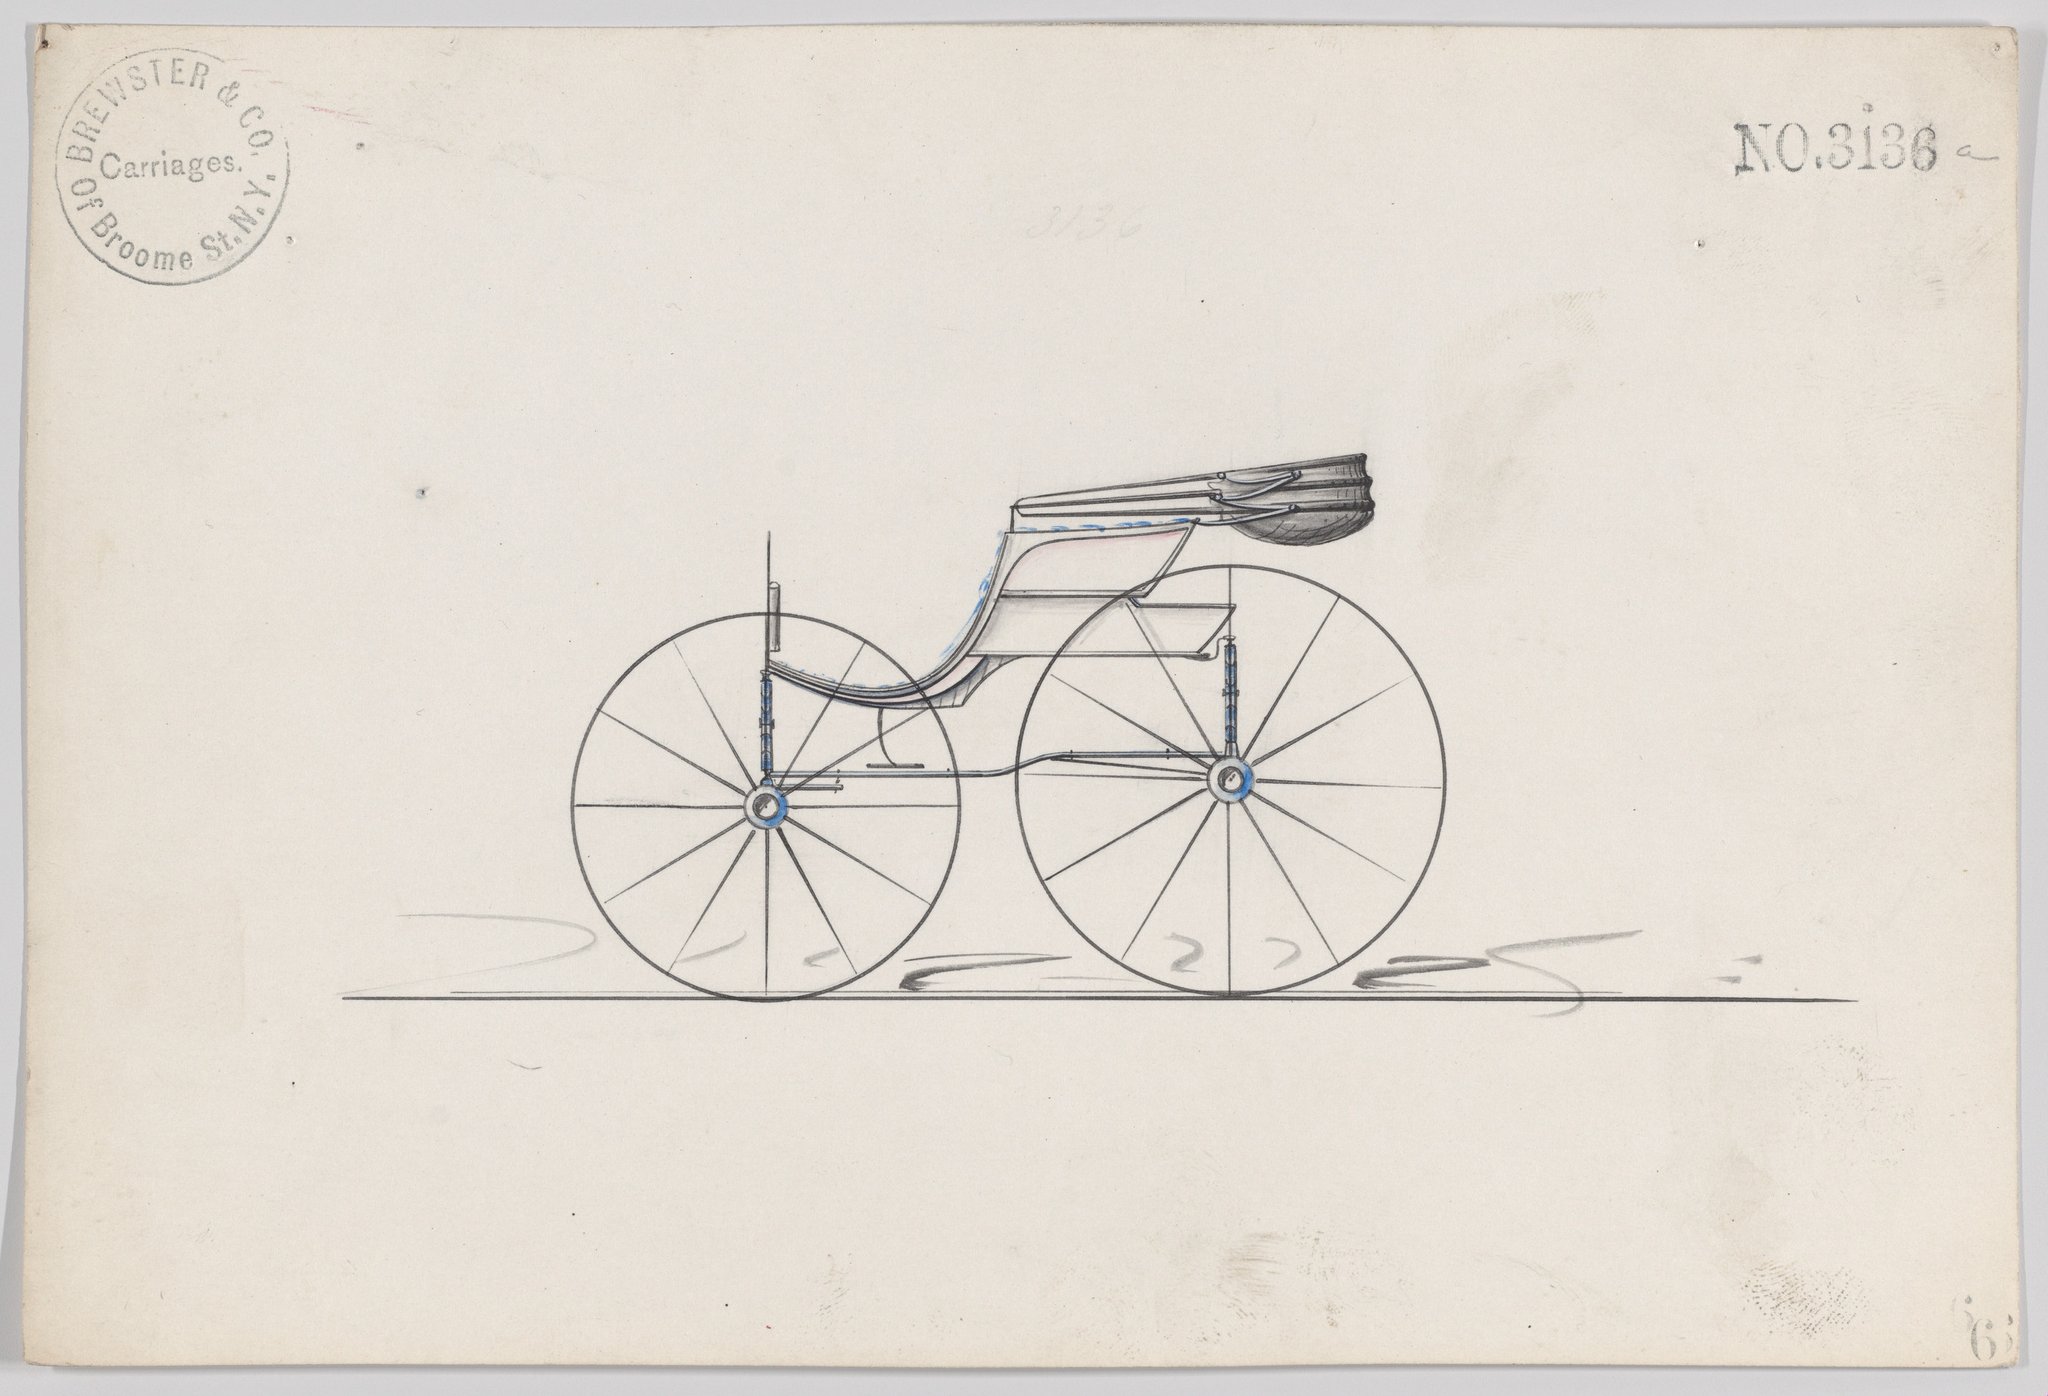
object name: drawing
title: Design for Pony Phaeton, no. 3136a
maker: brewster & co.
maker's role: manufacturer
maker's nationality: american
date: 1875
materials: gouache, ink, watercolor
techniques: pen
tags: carriages